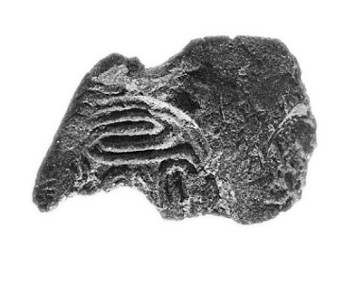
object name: sealing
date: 1981-1640 BCE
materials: mud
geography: egypt